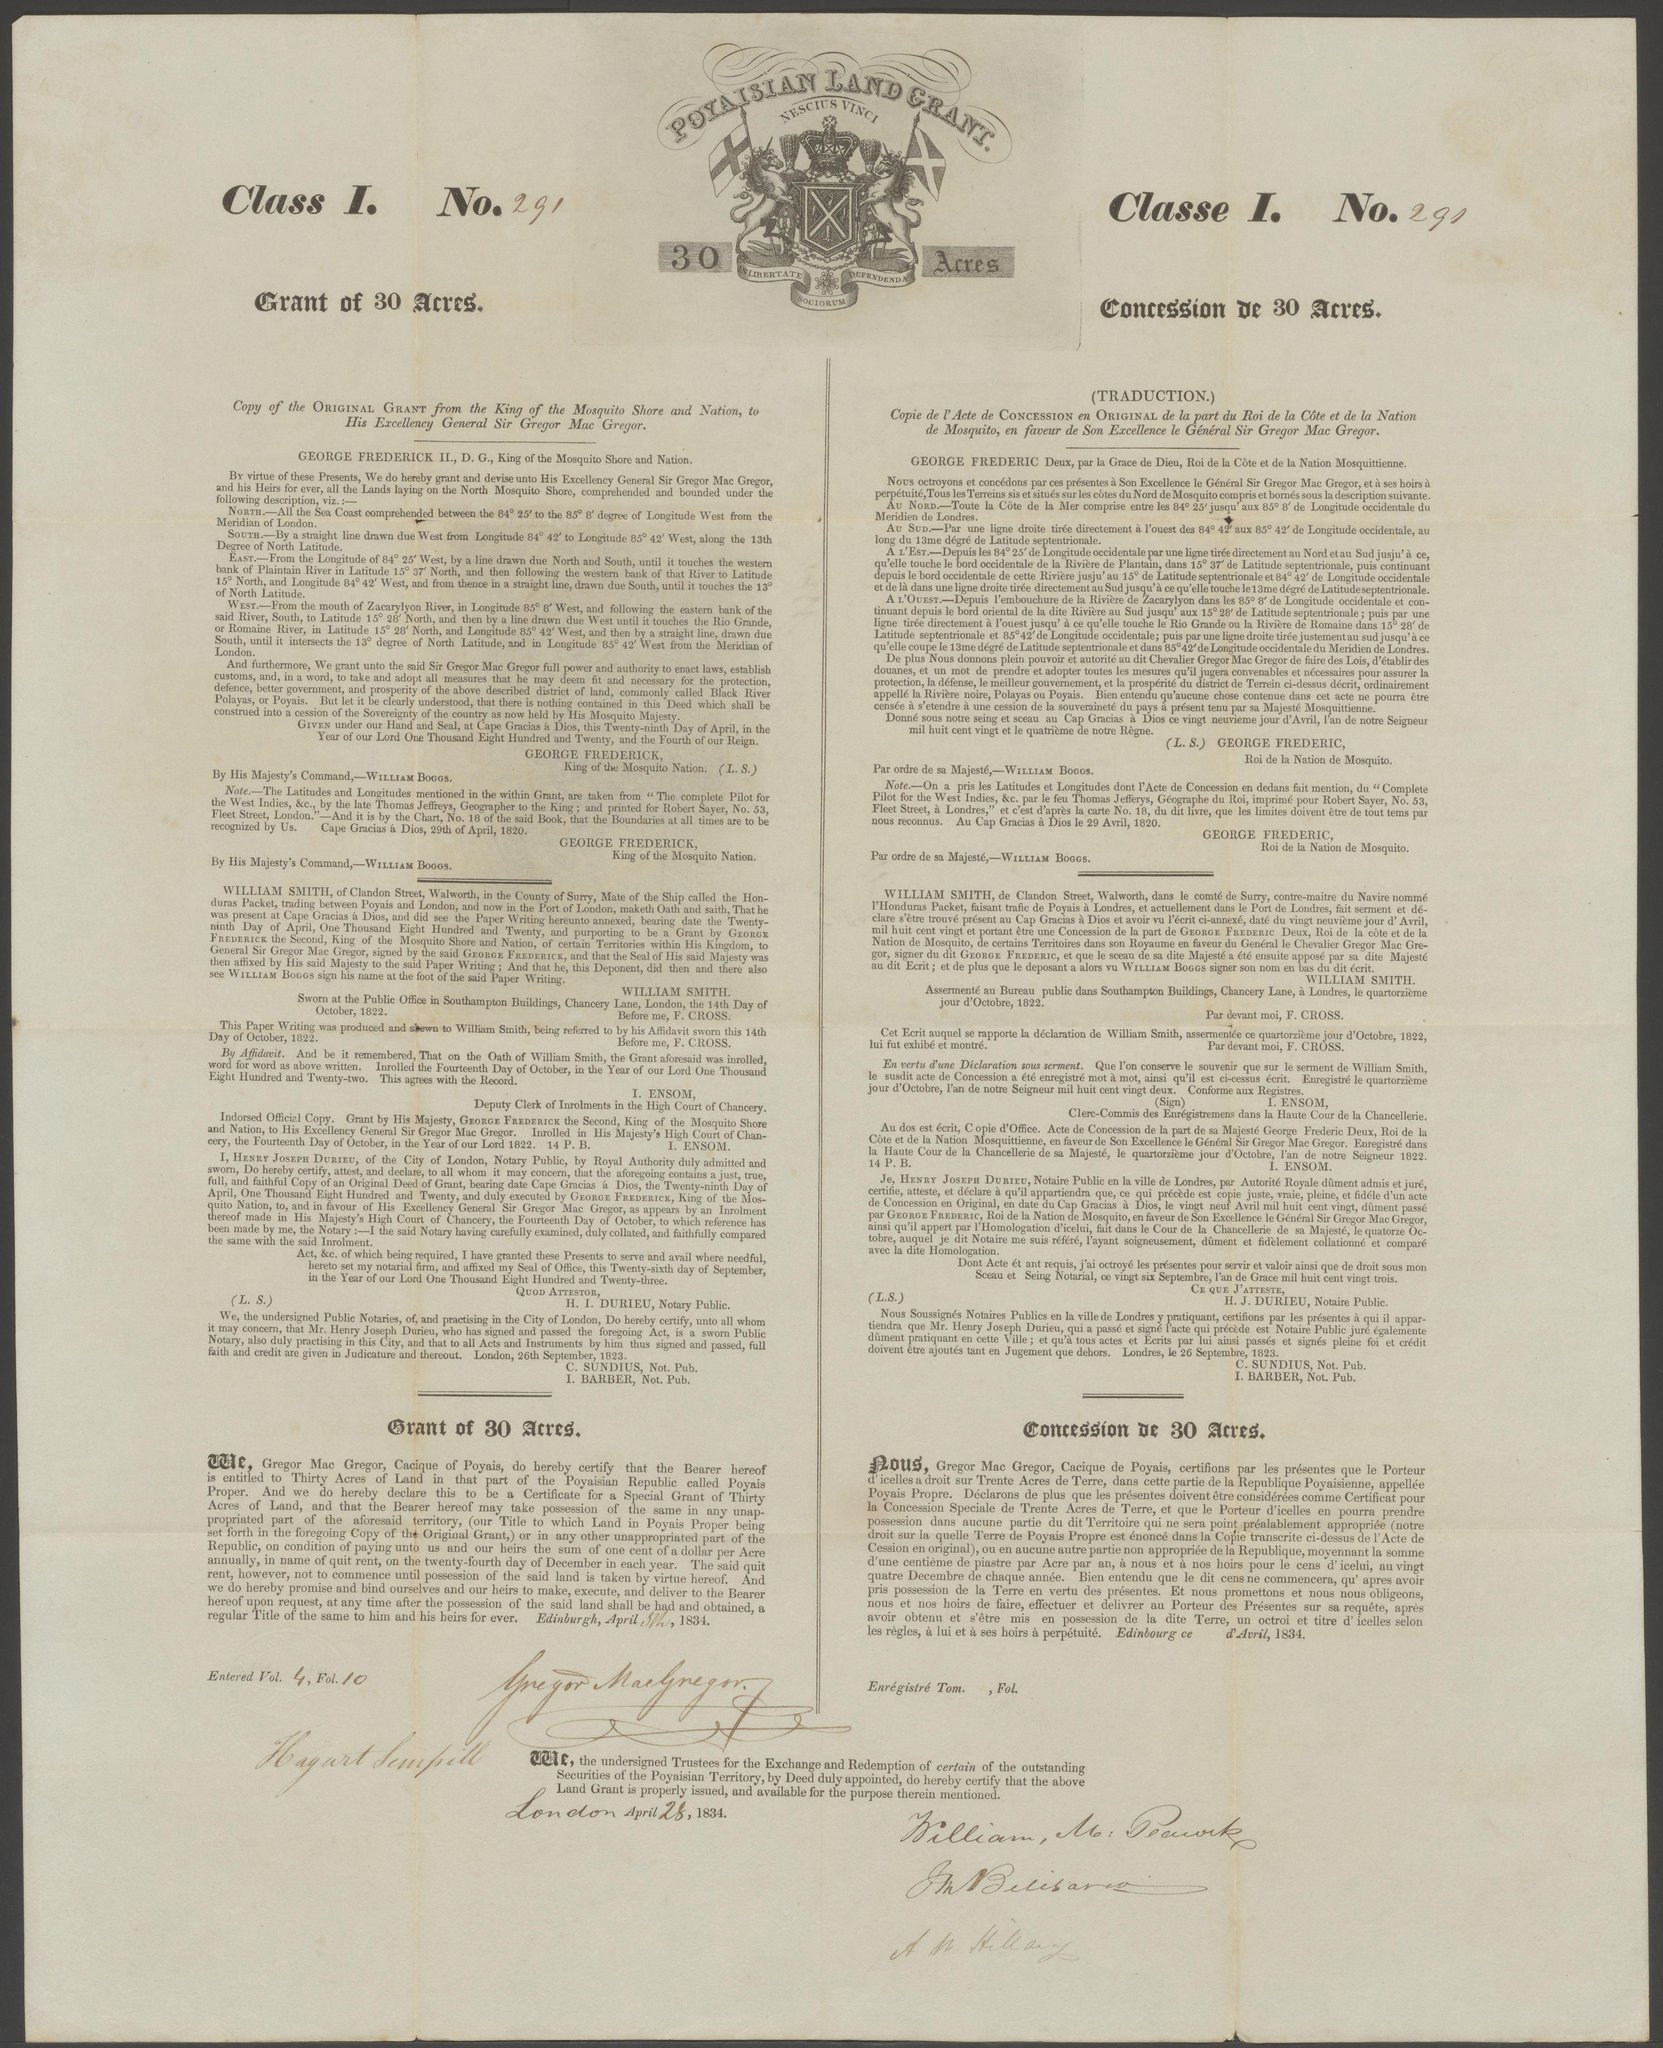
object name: print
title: Landcertificaat 30 acre op Poyais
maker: Anonymous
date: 1823-1834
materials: paper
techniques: etching, letterpress printing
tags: stock exchange, stock-market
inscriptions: check stamp, collector's mark: Lugt 1641b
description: In de negentiende eeuw verzon Gregor MacGregor de niet bestaande staat Poyais in Midden-Amerika. Hij verkocht staatsobligaties en landcertificaten. Daarnaast emigreerde 250 mensen naar de niet bestaande staat. Bovenaan genummerd: Class I. No. 291. Onderwerpsrubriek binnen de Atlas Amsterdam: Handel en Zeevaart, E. Spotprenten betreffende de Beurs.